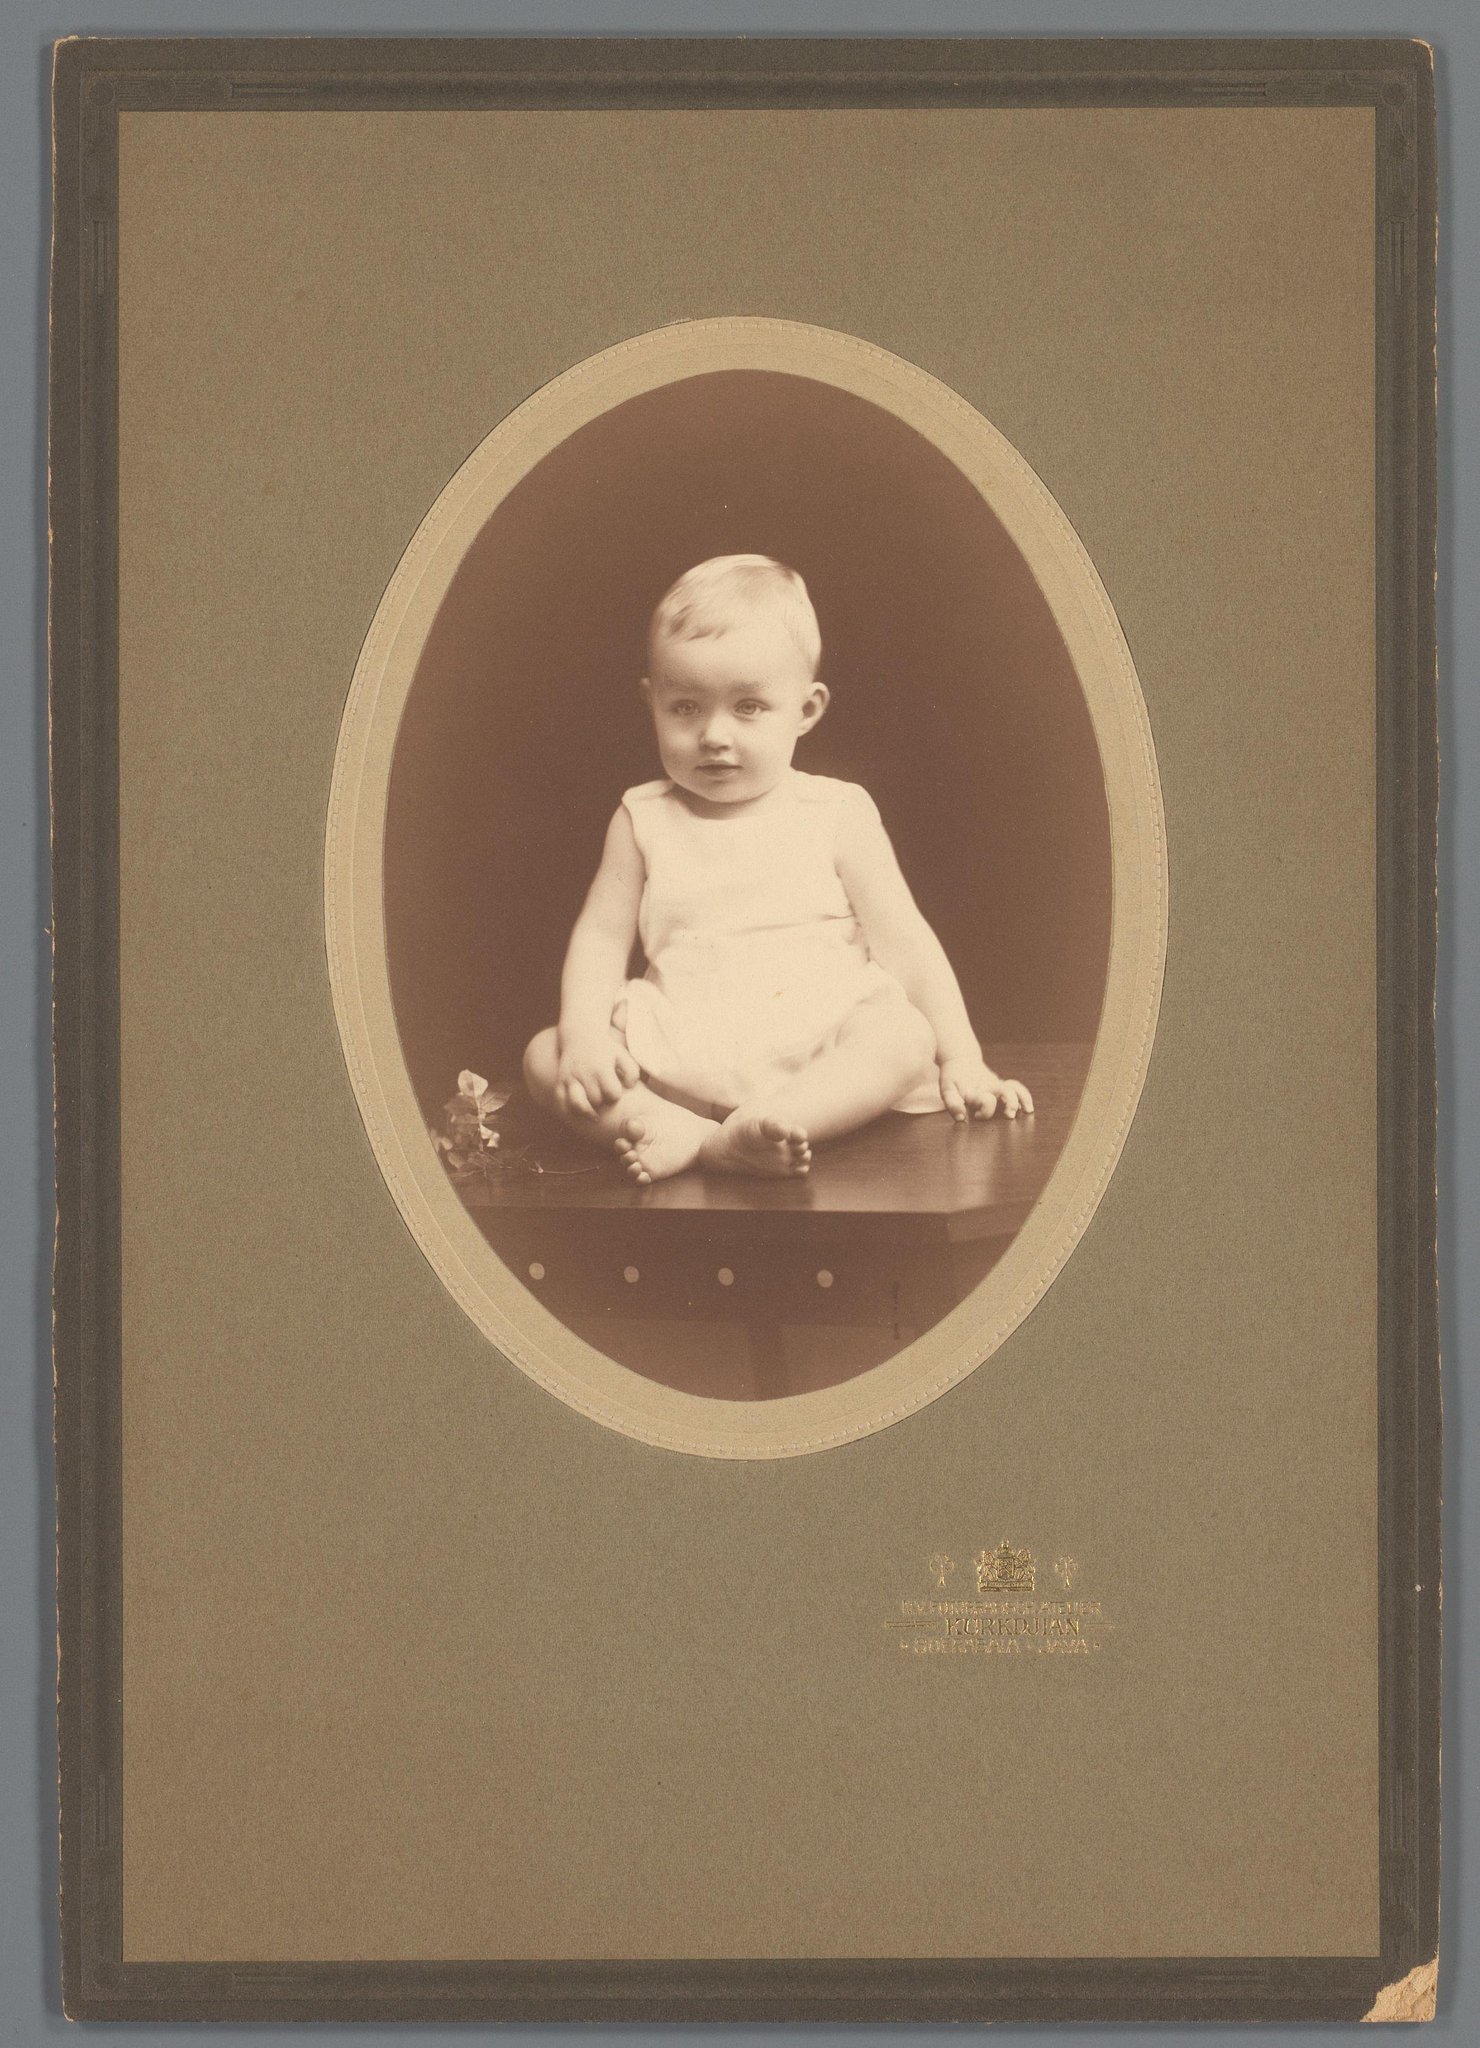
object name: photograph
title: Portret van een onbekend kind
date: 1911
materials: cardboard, paper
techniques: gelatin silver print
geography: surabaya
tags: infant, baby ~ the ages of man, historical persons not known by name, surabaya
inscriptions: date: ‘30 Juli 1911’, inscription: ‘N.V. Fotografisch Atelier/ Kurkdjian/ Soerabaia Java’